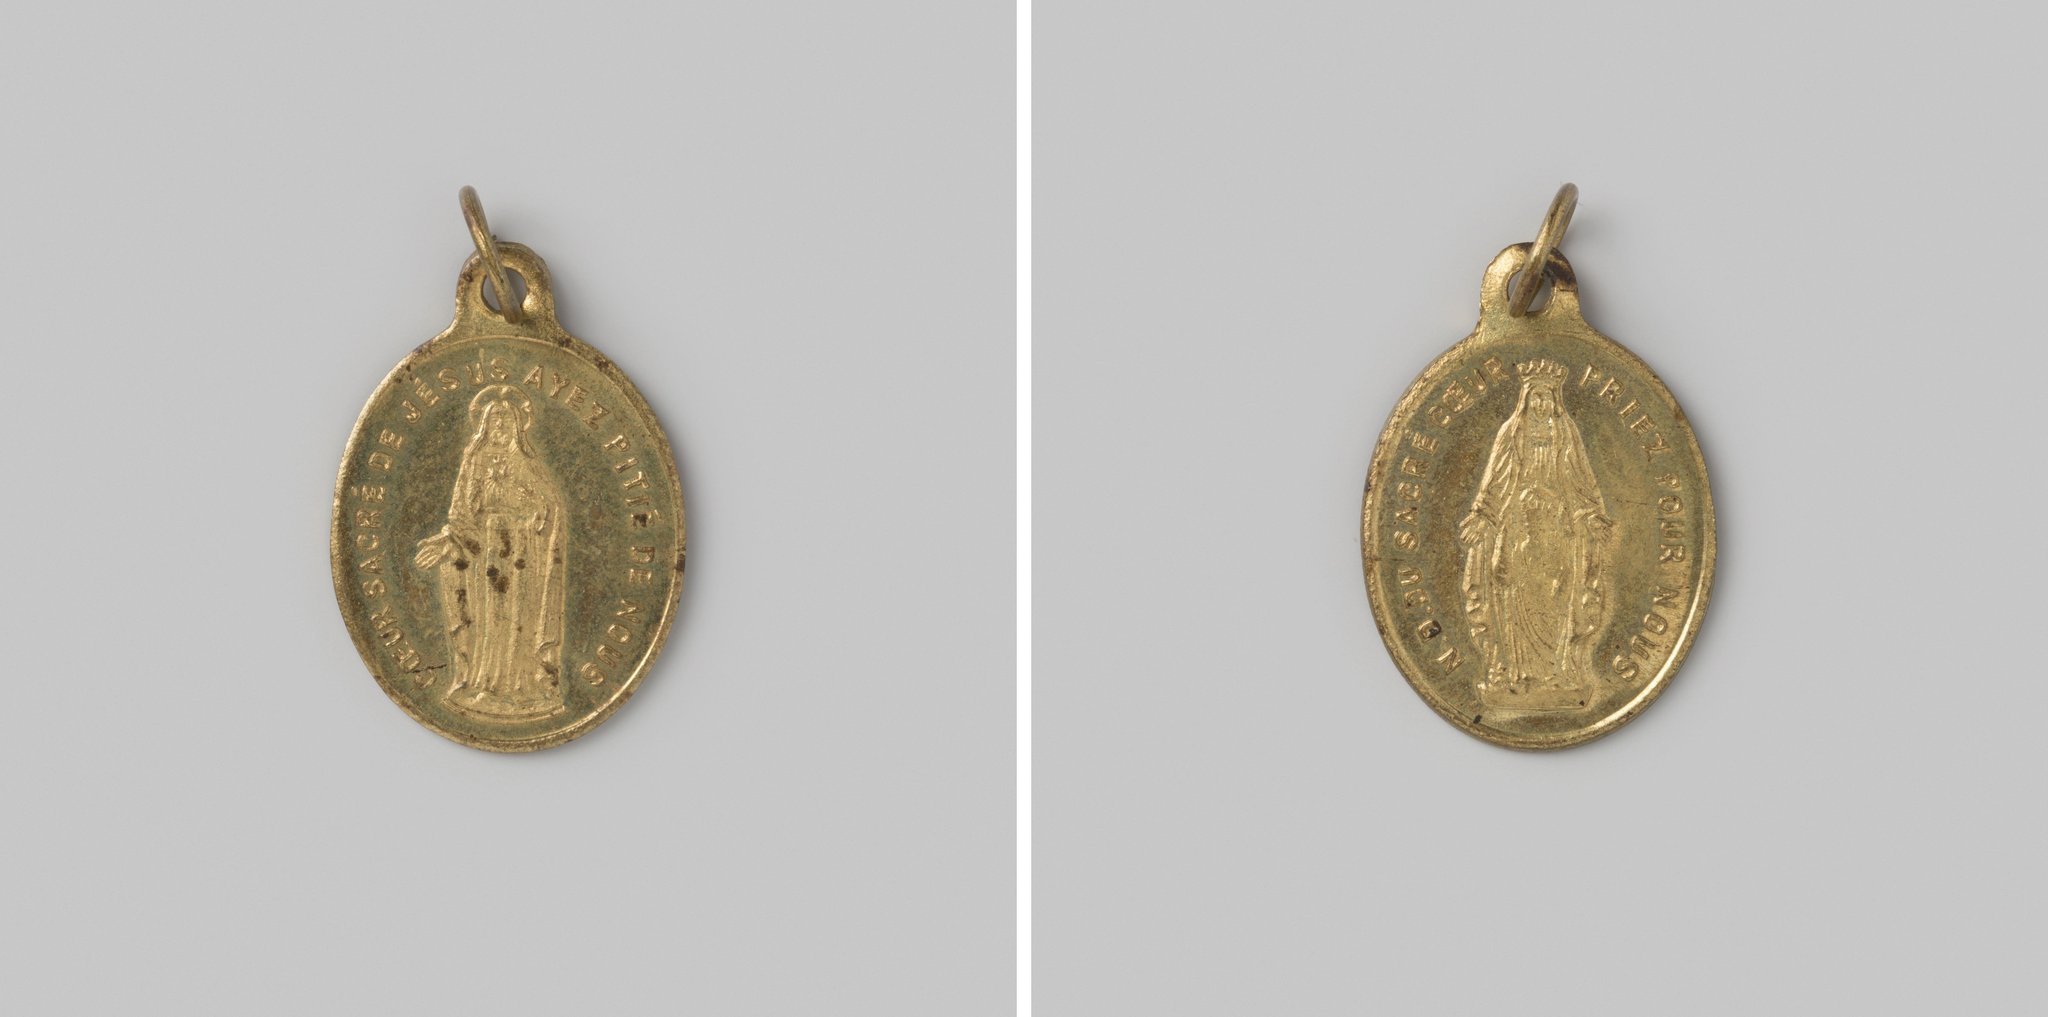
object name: history medal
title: Religieus draagteken Heilig Hart en Maria met Kind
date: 1750-1850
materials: brass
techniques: striking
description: Kleine ovalen messing penning met oog en draagring, op de voorzijde Jesus met Heilig Hart, met omschrift, op de keerzijde Maria met gekroond staand kind Jesus, met omschrift.